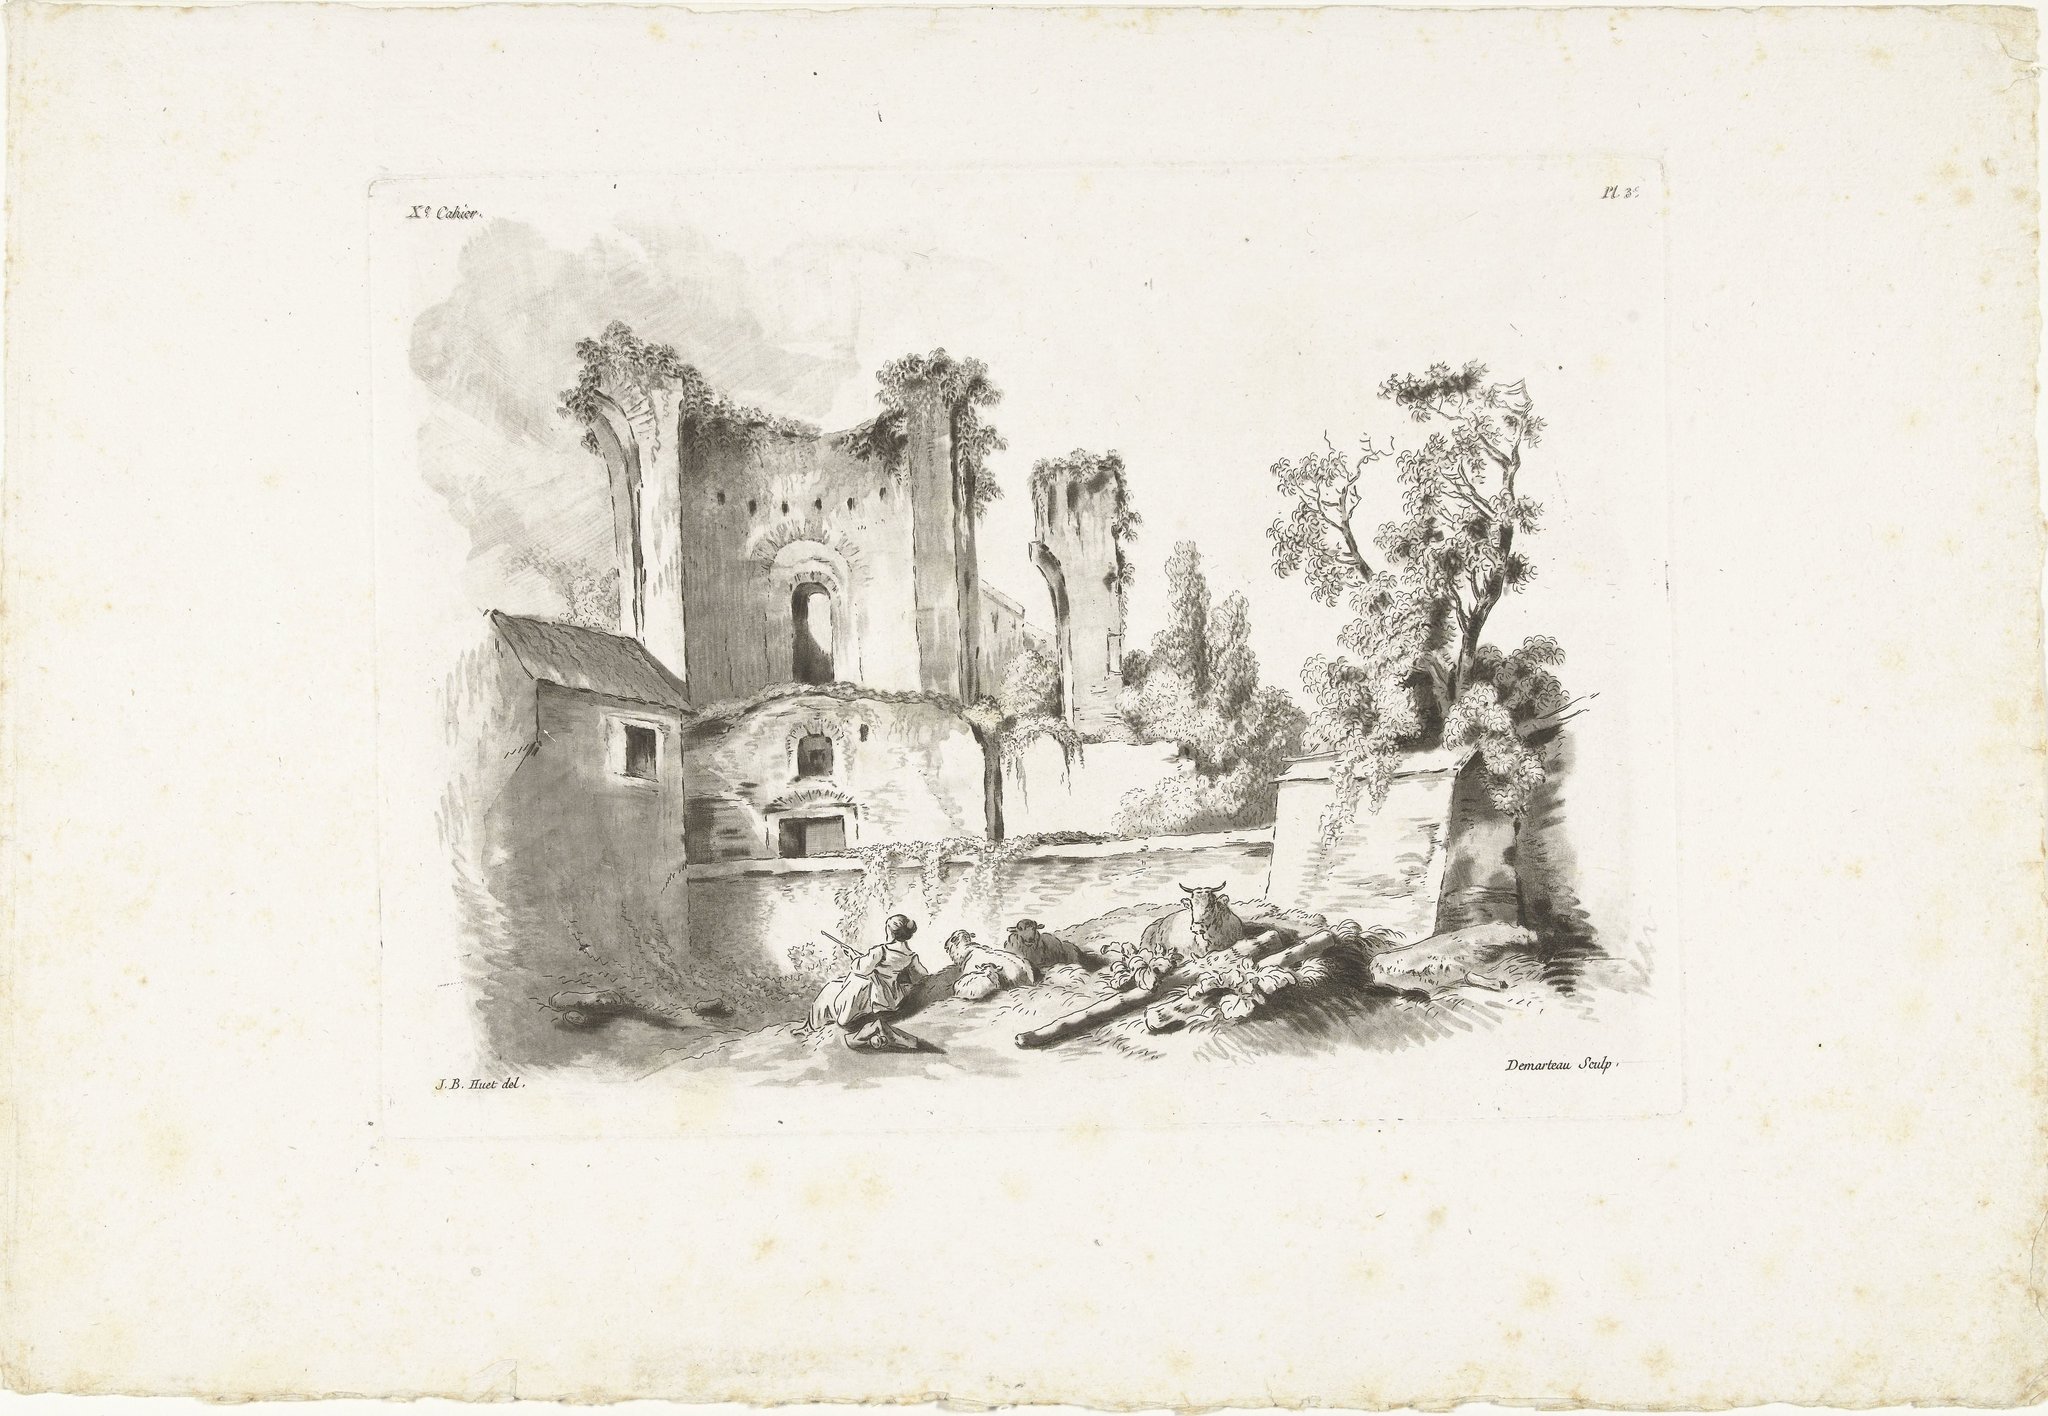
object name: print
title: Landschap met ruïne en herderin met vee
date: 1732-1776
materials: paper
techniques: printmaking, etching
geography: paris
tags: herding, herdsman, herdswoman, shepherd, shepherdess, cowherd, etc., landscape with ruins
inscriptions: collector's mark: Lugt 2233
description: Prent gebruikt als illustratie in onbekende uitgave, Xe Cahier, plaat 3.